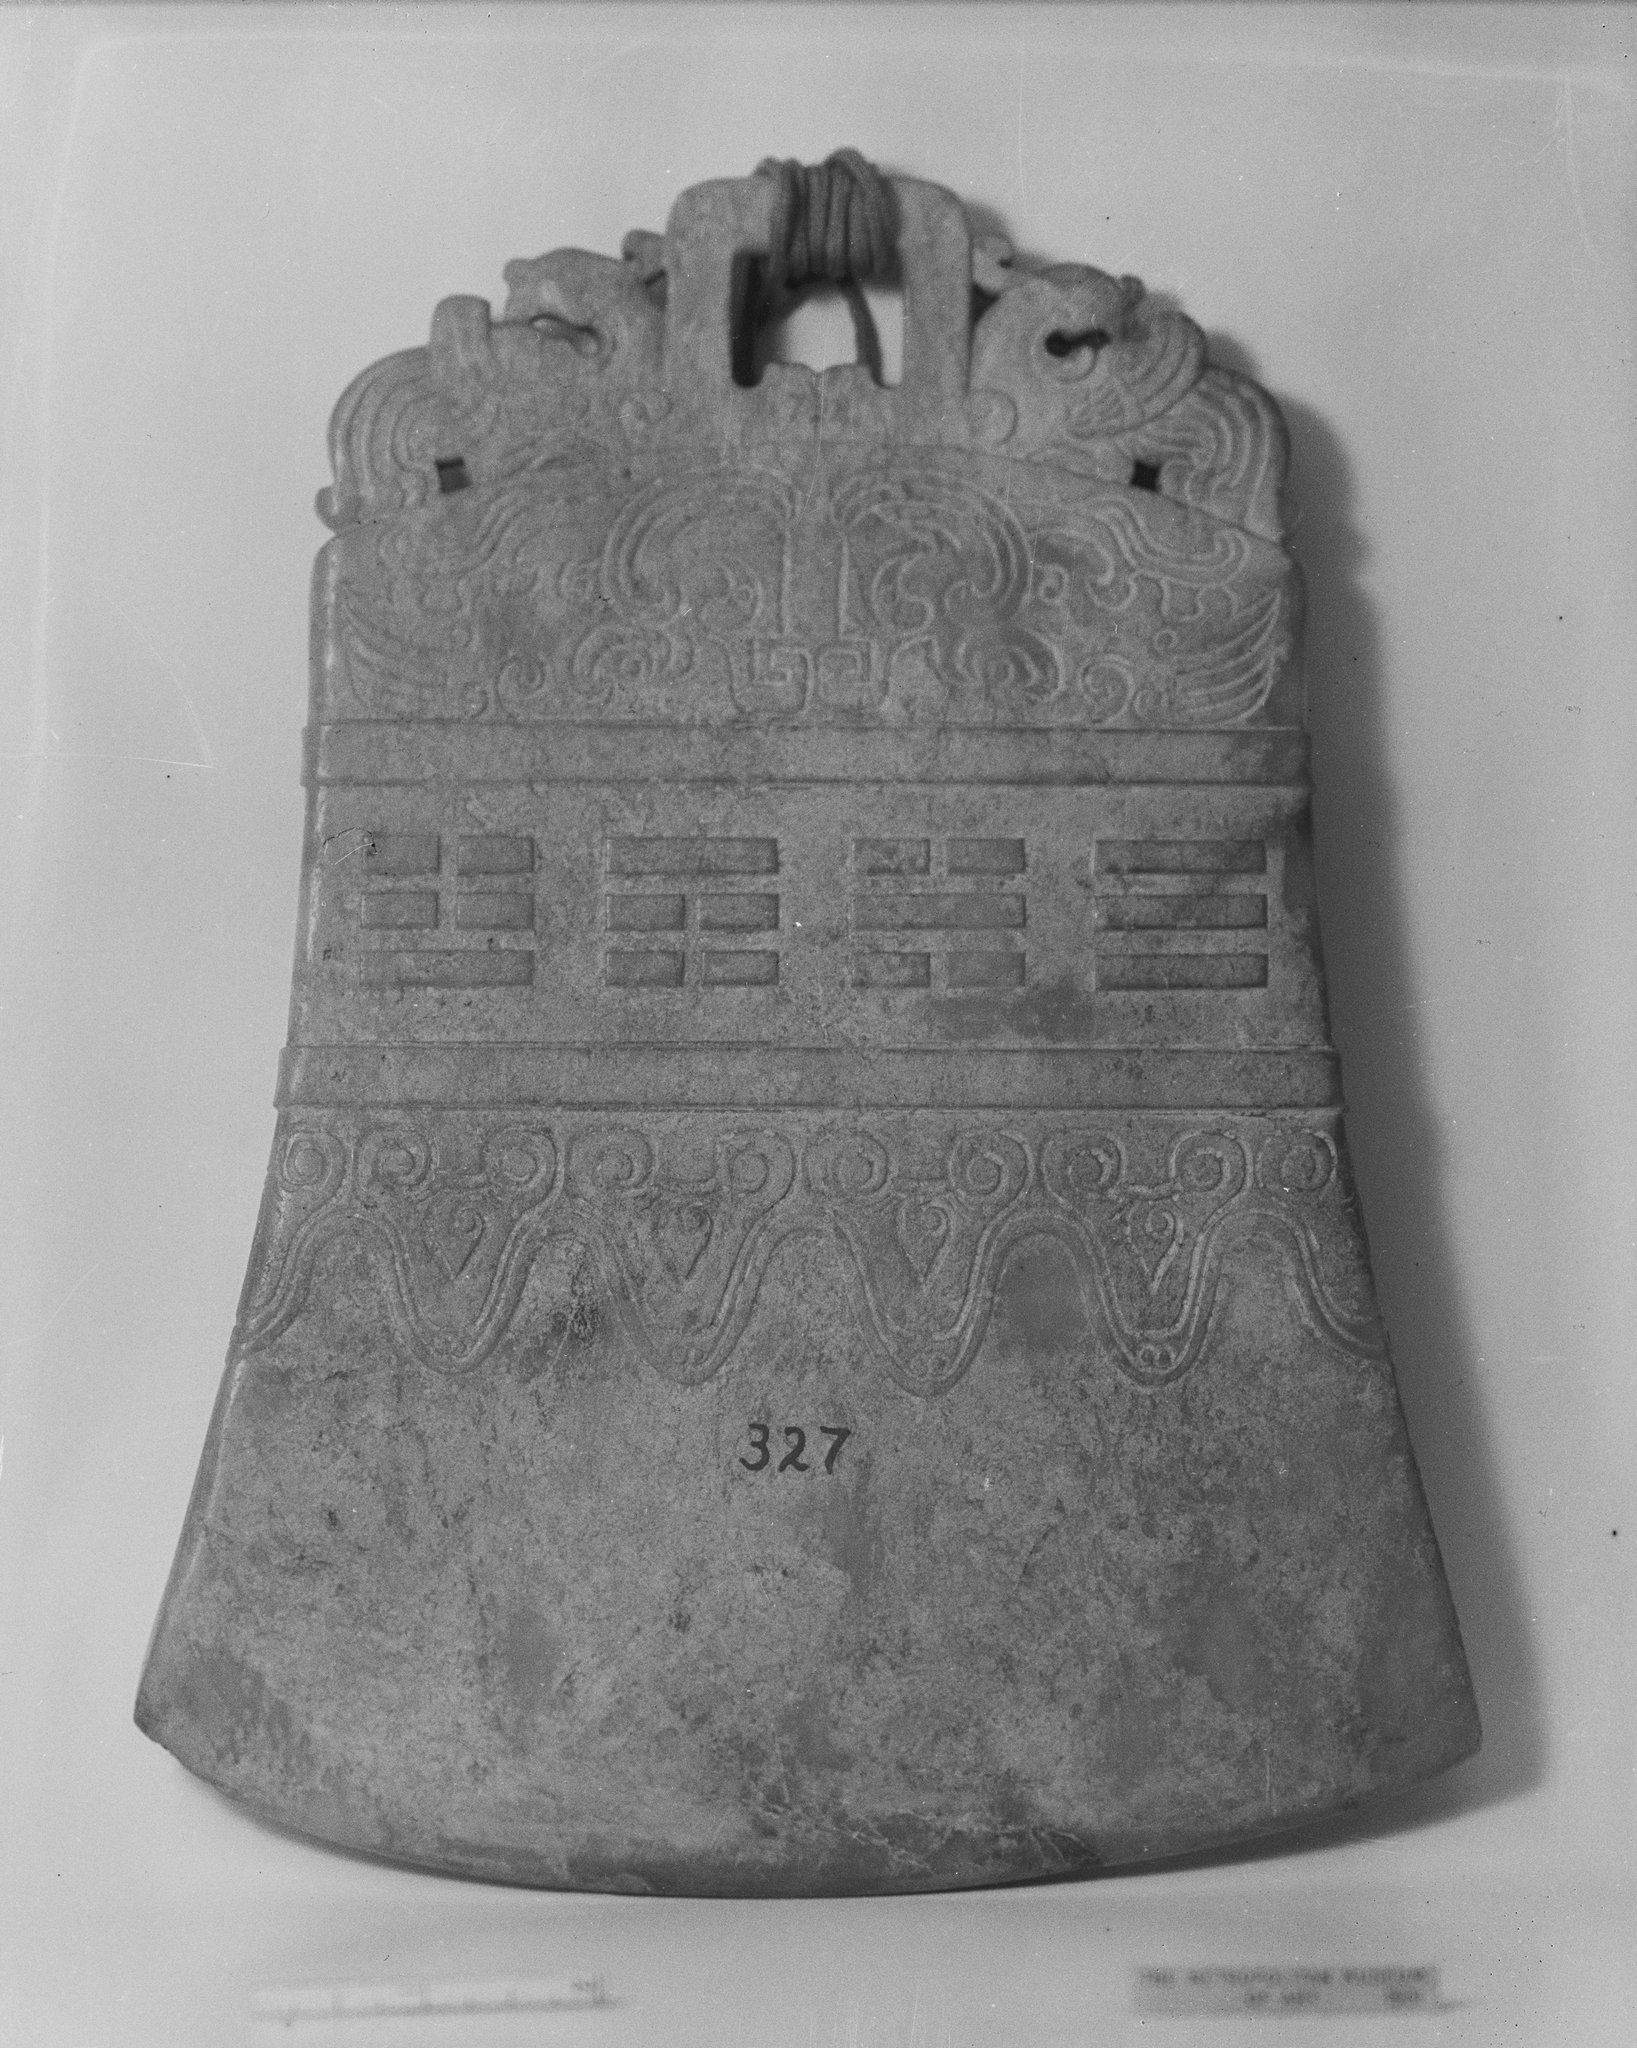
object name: gong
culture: chinese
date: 206 BCE-220 CE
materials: jade